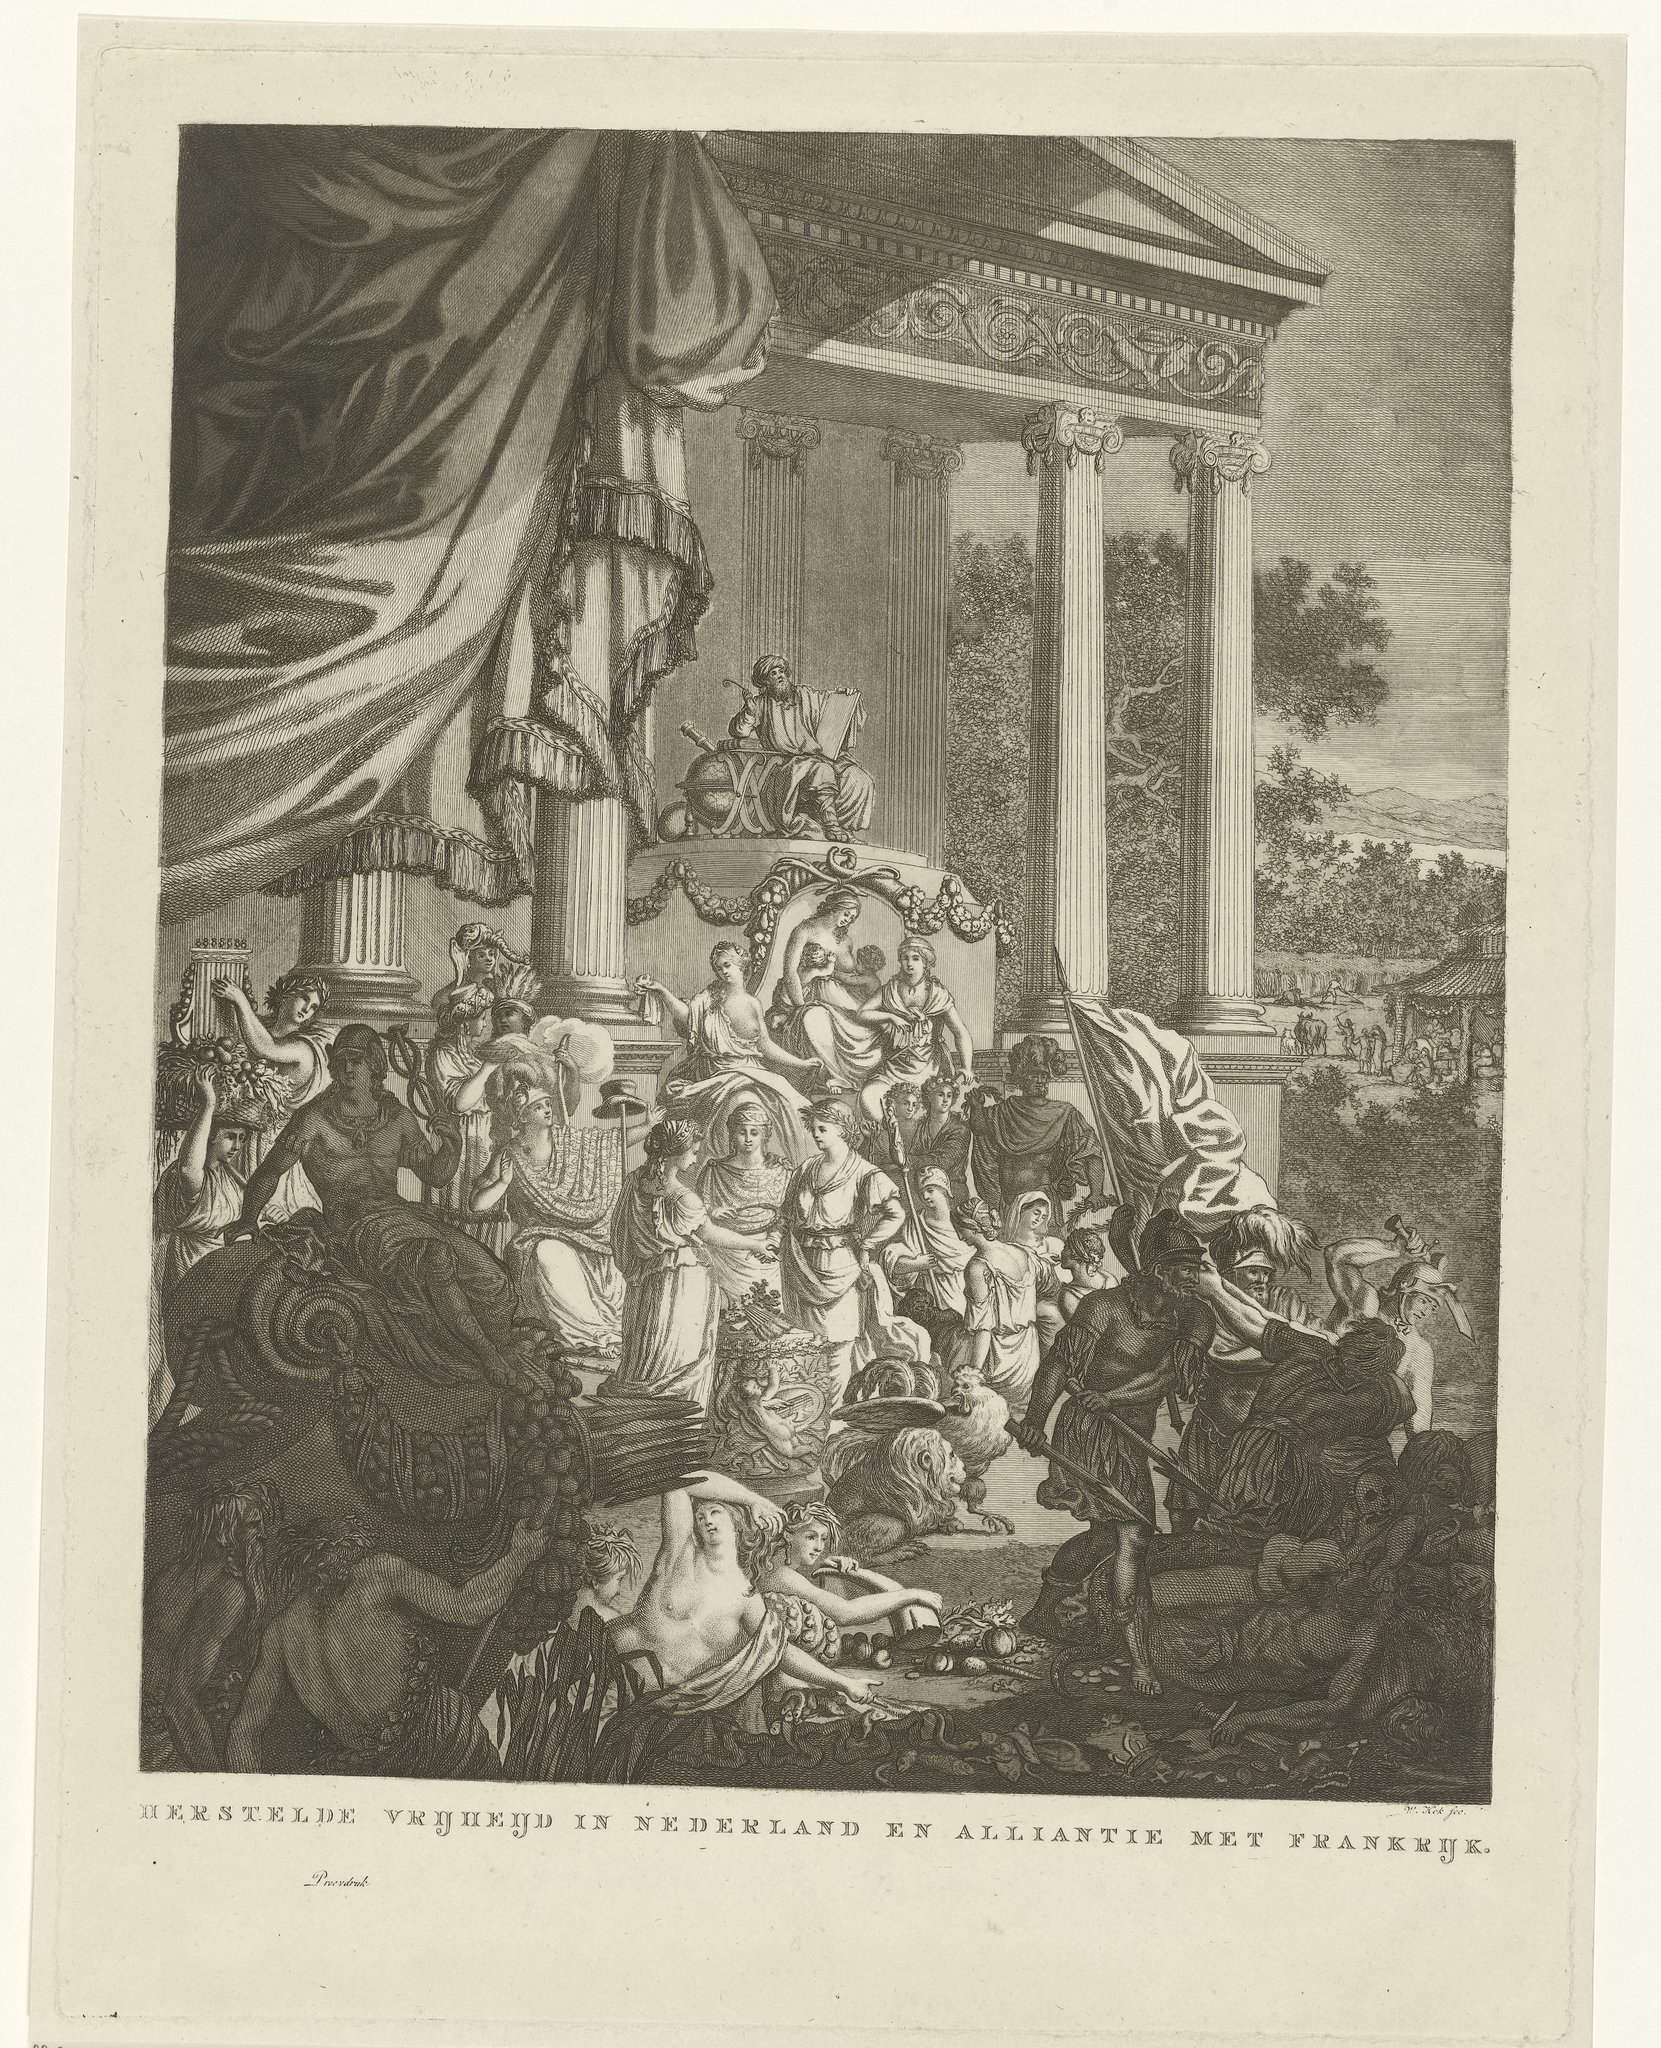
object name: print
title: Allegorische voorstelling op het bondgenootschap tussen Nederland en Frankrijk, 1795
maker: willem kok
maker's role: draughtsman, print maker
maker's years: 1761-1807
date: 1795-1800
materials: paper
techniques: engraving, etching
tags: (story of) mercury (hermes) - apotheosis, deification, serpent ouroboros, attributes of aesculapius: cock, freedom, liberty; 'libertà' (ripa), beasts of prey, predatory animals: lion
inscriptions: collector's mark: Lugt 2228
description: Allegorische voorstelling op het bondgenootschap tussen Nederland en Frankrijk, 1795. In het midden worden de Nederlandse Maagd en Franse Republiek (als jongeman) door de Vrijheid in het echt verbonden, met het teken van eeuwigheid: een ring gevormd door een slang die in zijn eigen staart bijt. Voor het huwelijkspaar bevinden zich een haan en een leeuw en achter hen staat een dame met de vrijheidshoed op een lans. Links op de voorgrond zit Mercurius en onder hem bevinden zich enkele zeegoden. Rechts een aantal moordende (overwinnende) soldaten en op de achtergrond een tempel.